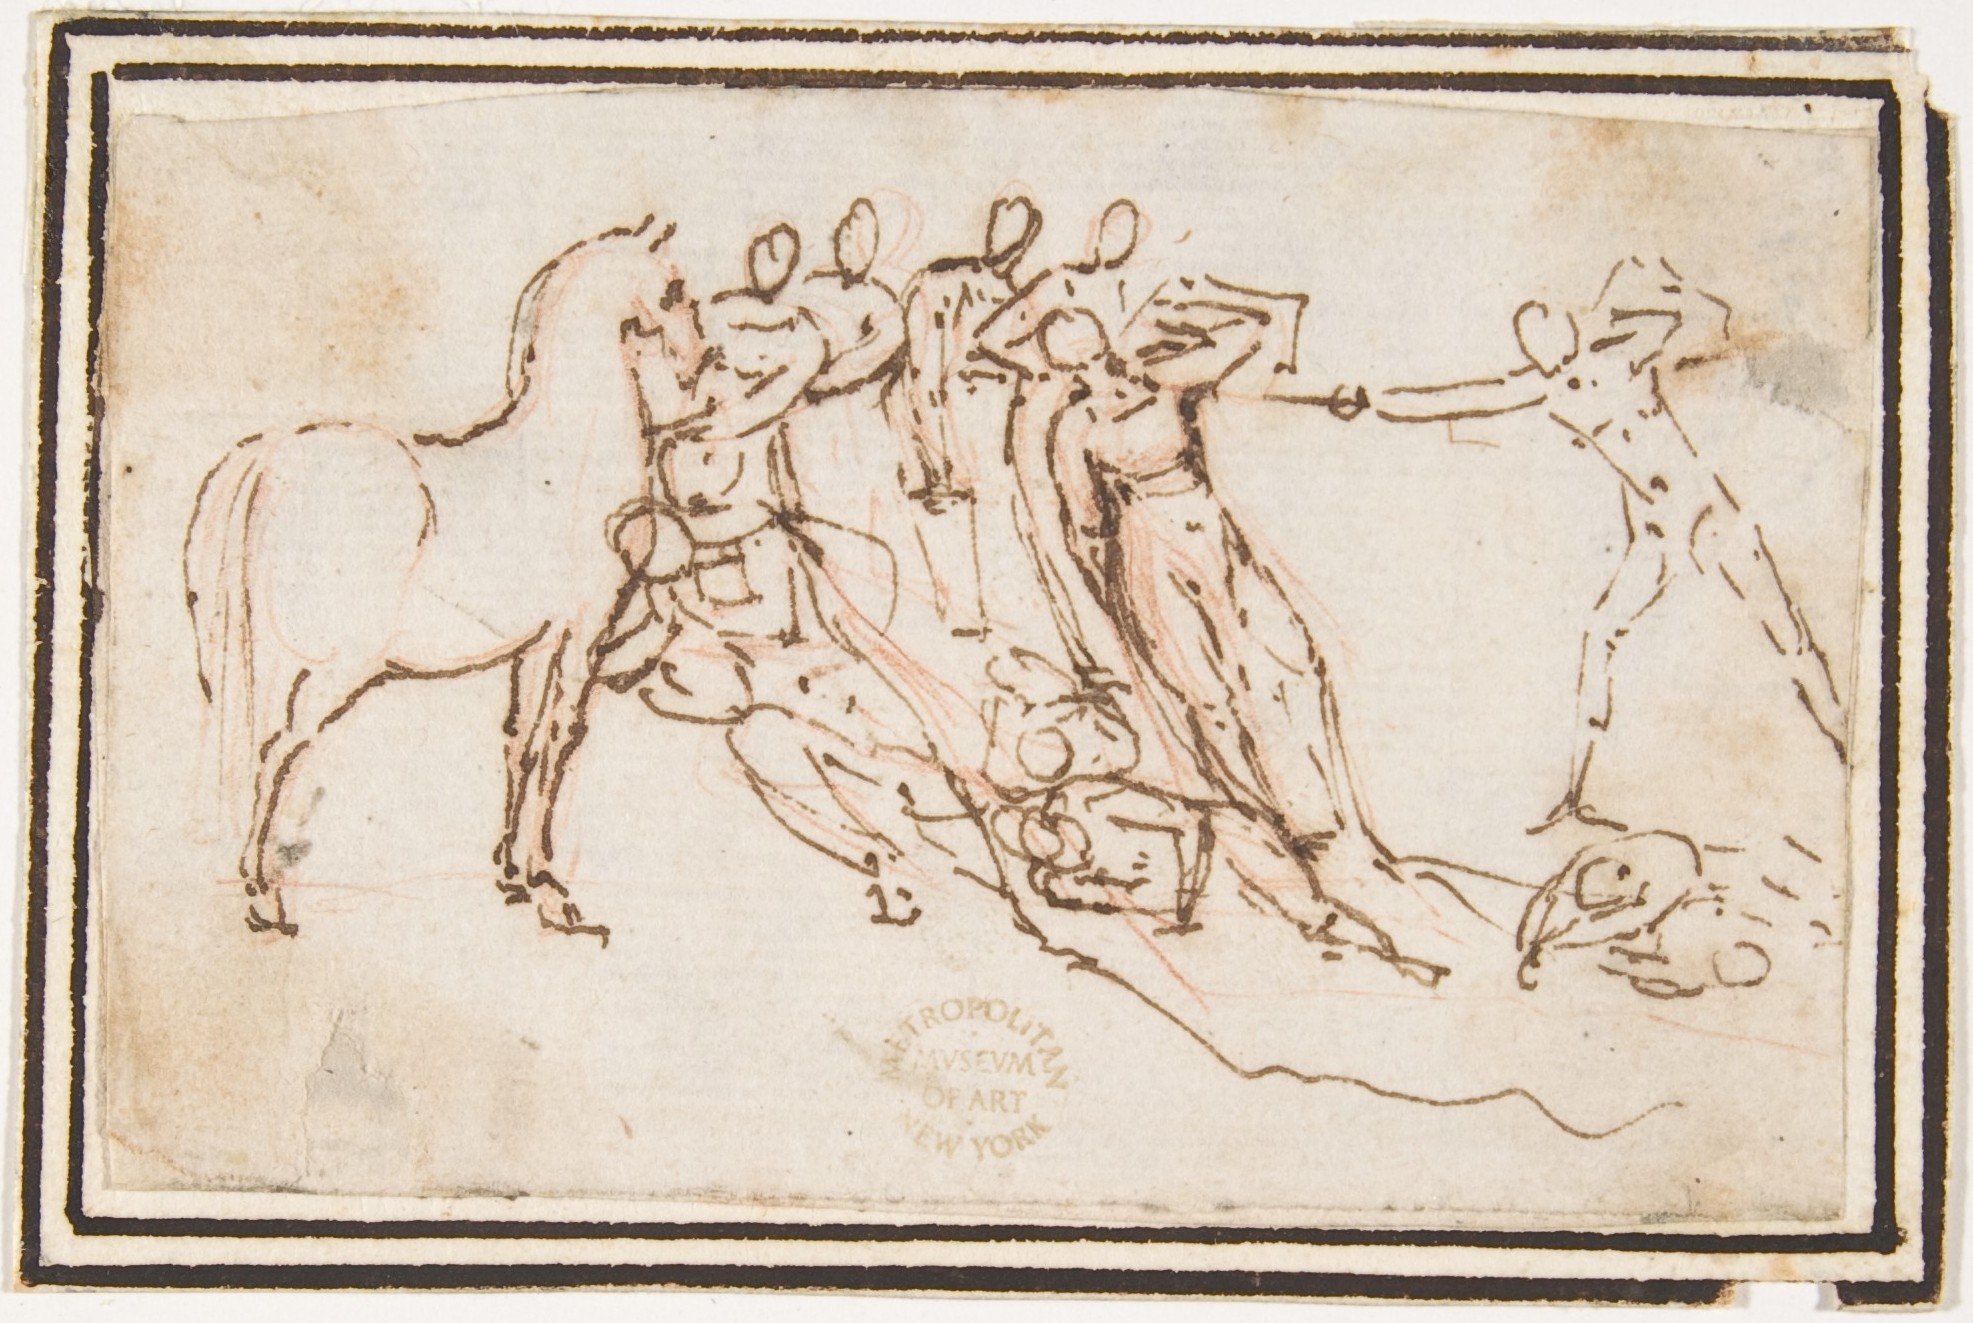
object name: drawing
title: Unidentified Subject (Nine Figures and a Horse)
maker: francesco allegrini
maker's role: artist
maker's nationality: italian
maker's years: 1615-1679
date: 1624-1663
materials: chalk, ink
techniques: pen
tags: human figures,horses